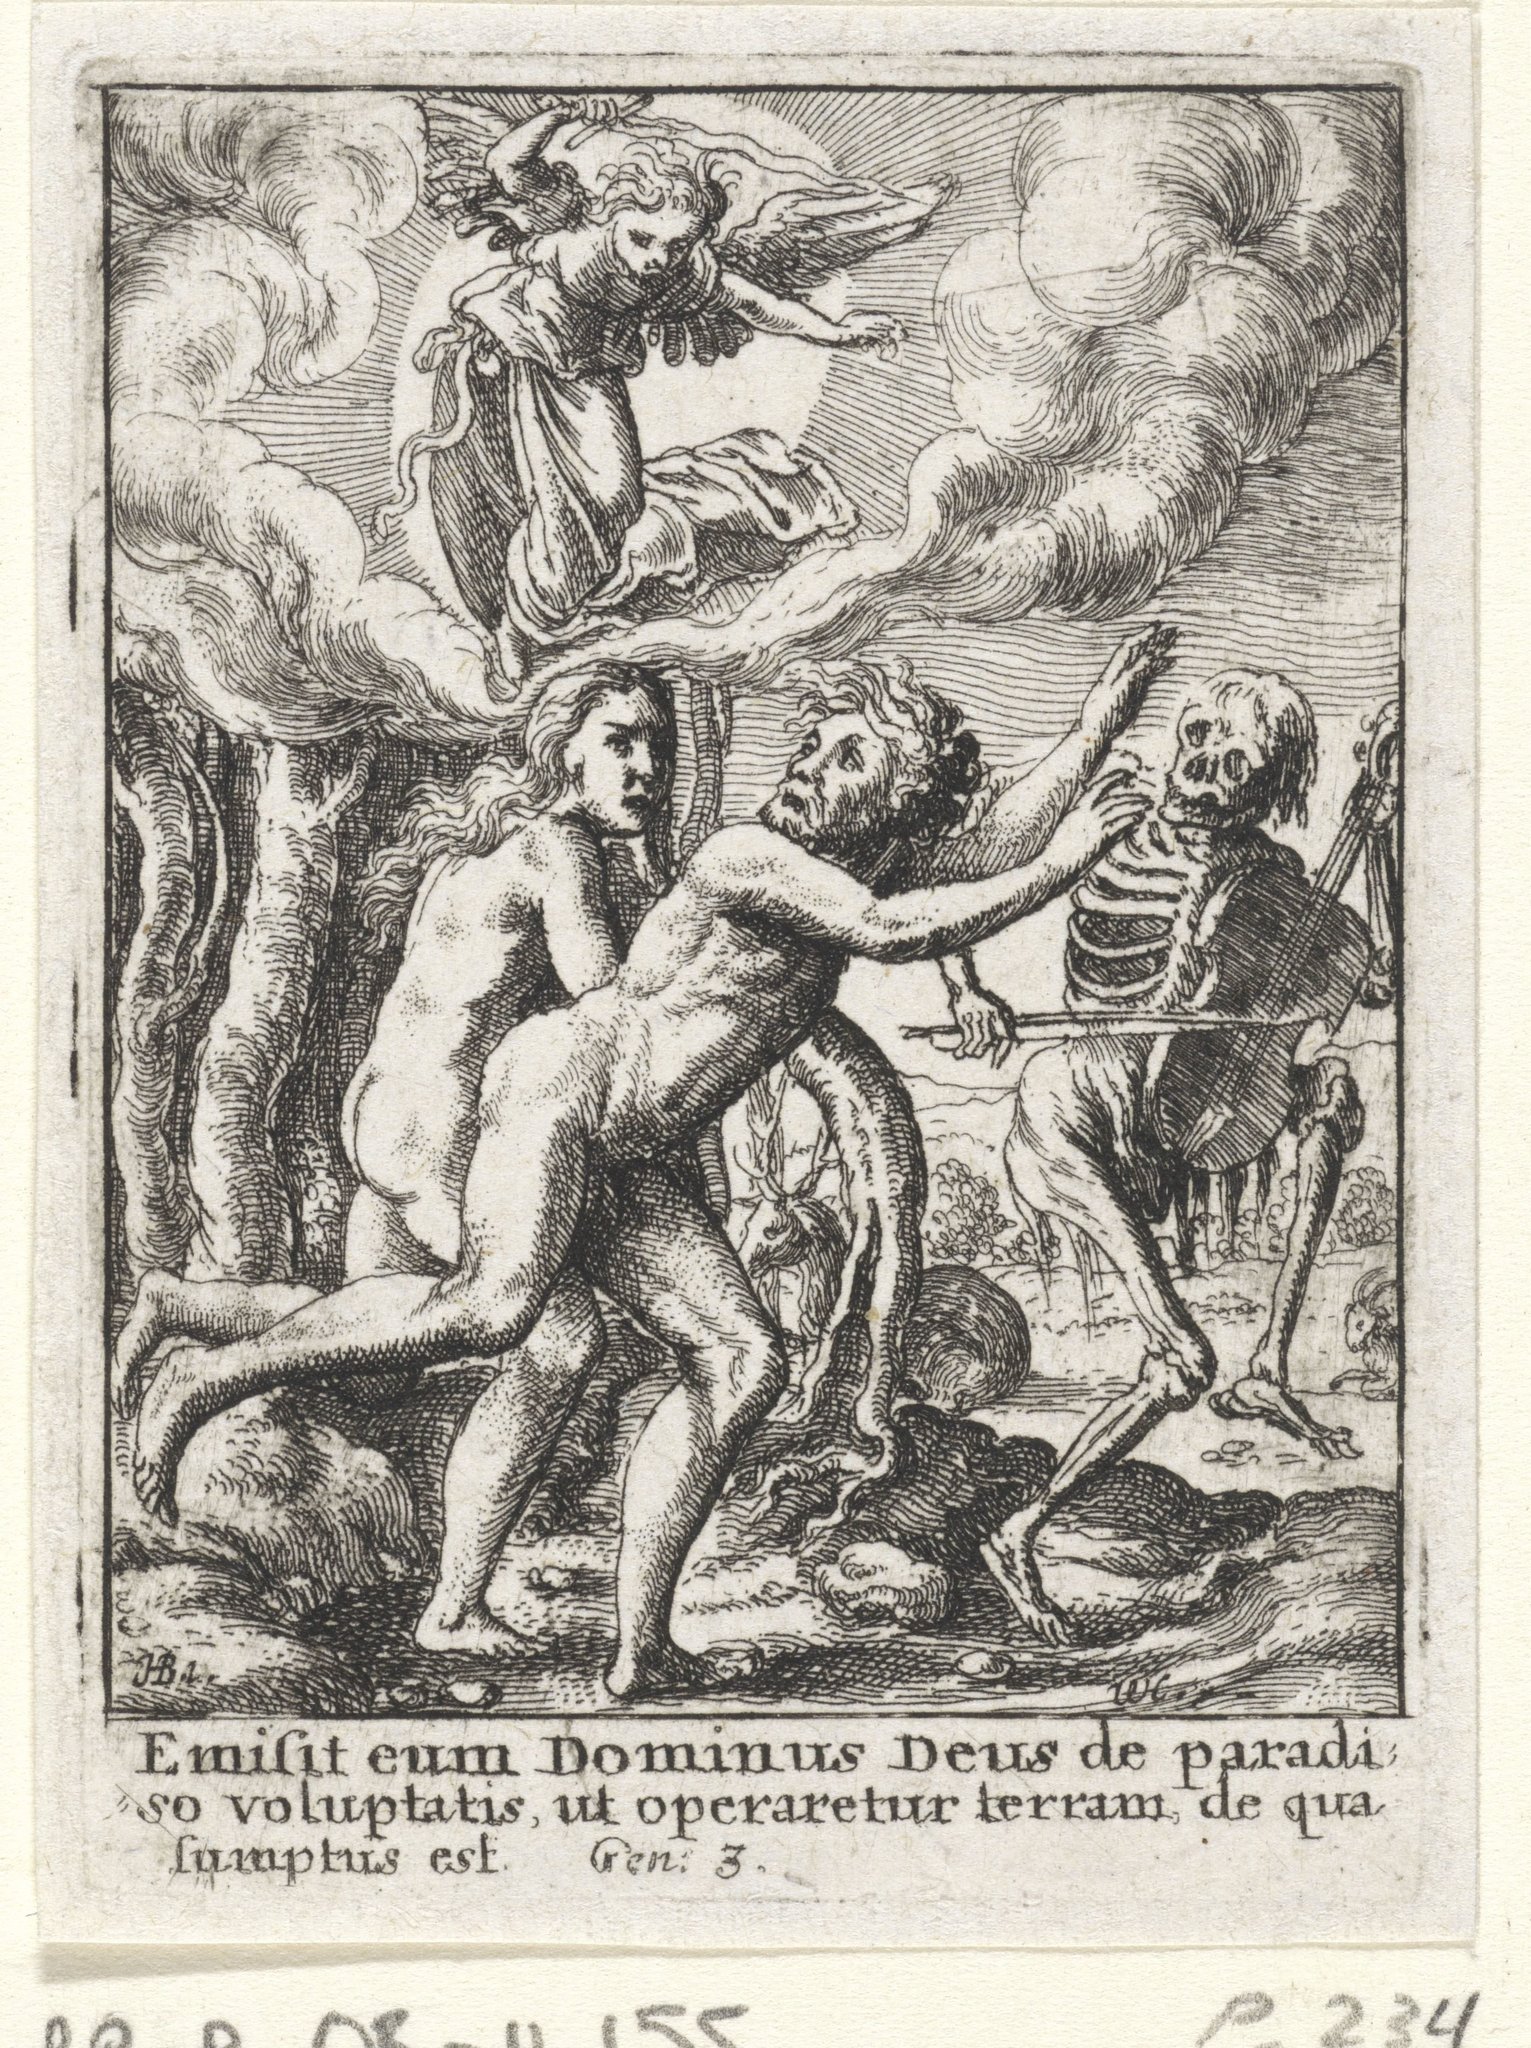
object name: book illustration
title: Adam en Eva verdreven uit het Paradijs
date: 1680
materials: paper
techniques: etching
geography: antwerp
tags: dance of death; death together with one or more human beings, an angel chases adam and eve out of paradise with a (flaming) sword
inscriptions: collector's mark: Lugt 240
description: Adam en Eva worden uit het Paradijs verdreven door een engel met een zwaard. De Dood leidt hen al vioolspelend het Paradijs uit.